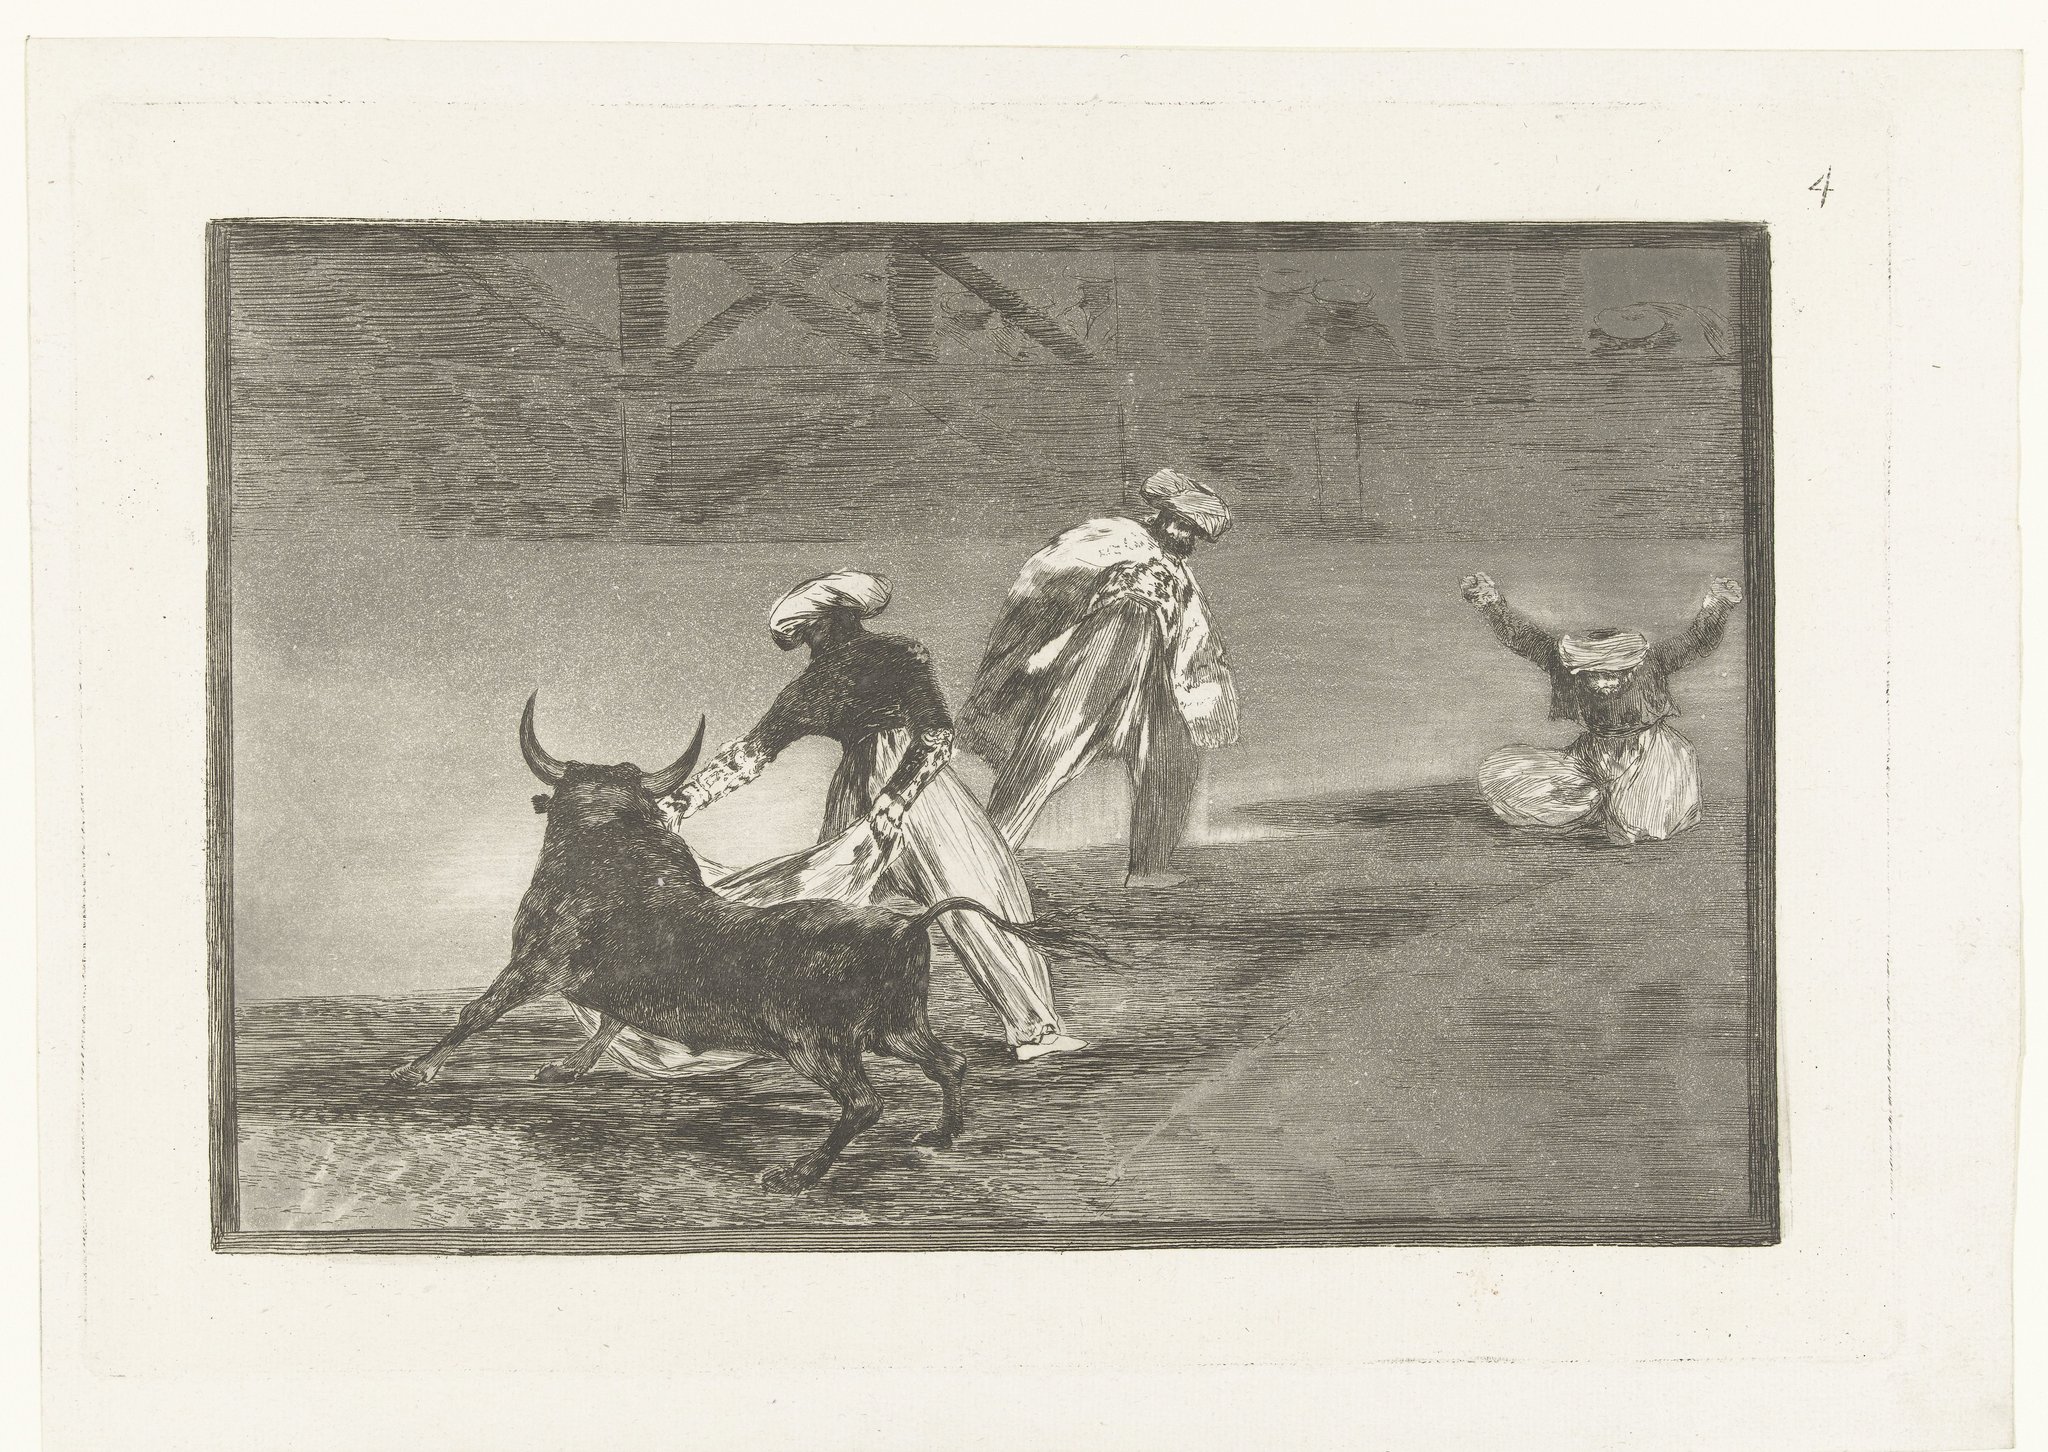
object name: print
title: Stierenvechters in een arena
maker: francisco de goya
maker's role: draughtsman, painter, print maker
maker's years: 1746-1828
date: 1811-1816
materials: paper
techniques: aquatint, drypoint, etching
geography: spain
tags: bull, bullfight, head-gear: turban, bull-fighter, toreador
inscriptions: collector's mark: Lugt 805b, collector's mark: Lugt 2228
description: Drie torero's (stierenvechters) in Moorse kledij vechten met een stier in een arena.